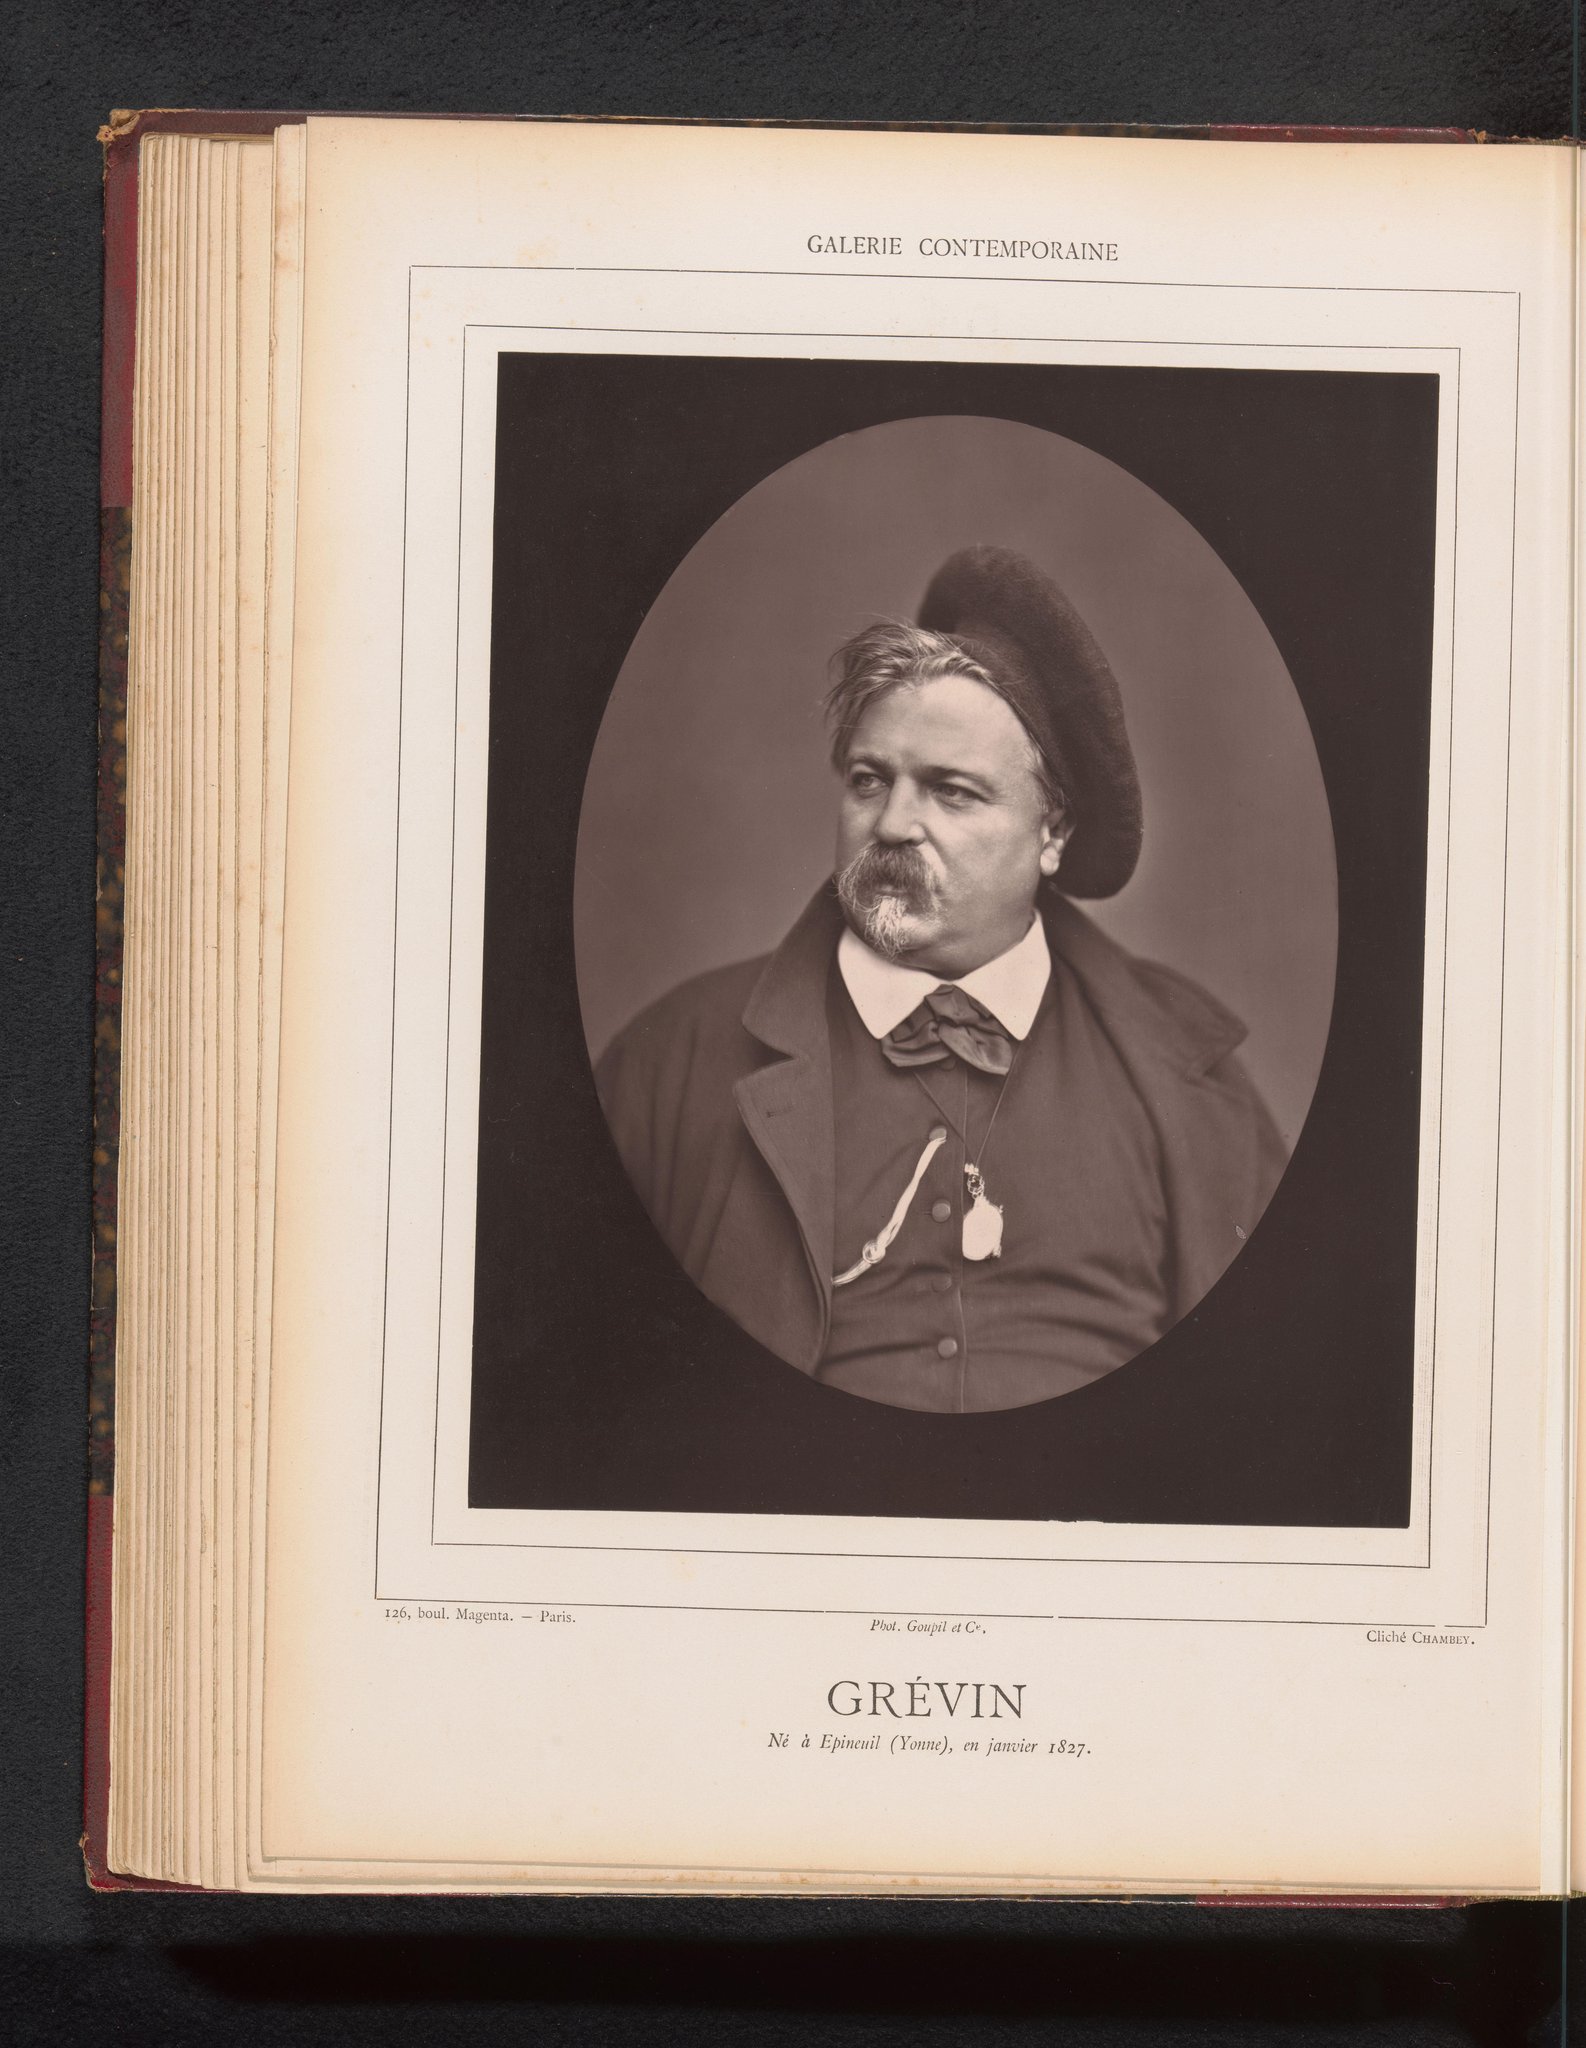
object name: page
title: Portret van Alfred Grévin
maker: chambey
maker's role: fotograaf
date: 1871-1876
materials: paper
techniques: woodburytype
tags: print maker, draughtsman, alfred grévin, adult man, historical persons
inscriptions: inscription: ‘126, boul. Magenta. - Paris./ Né à Epineuil (Yonne), en janvier 1827.’